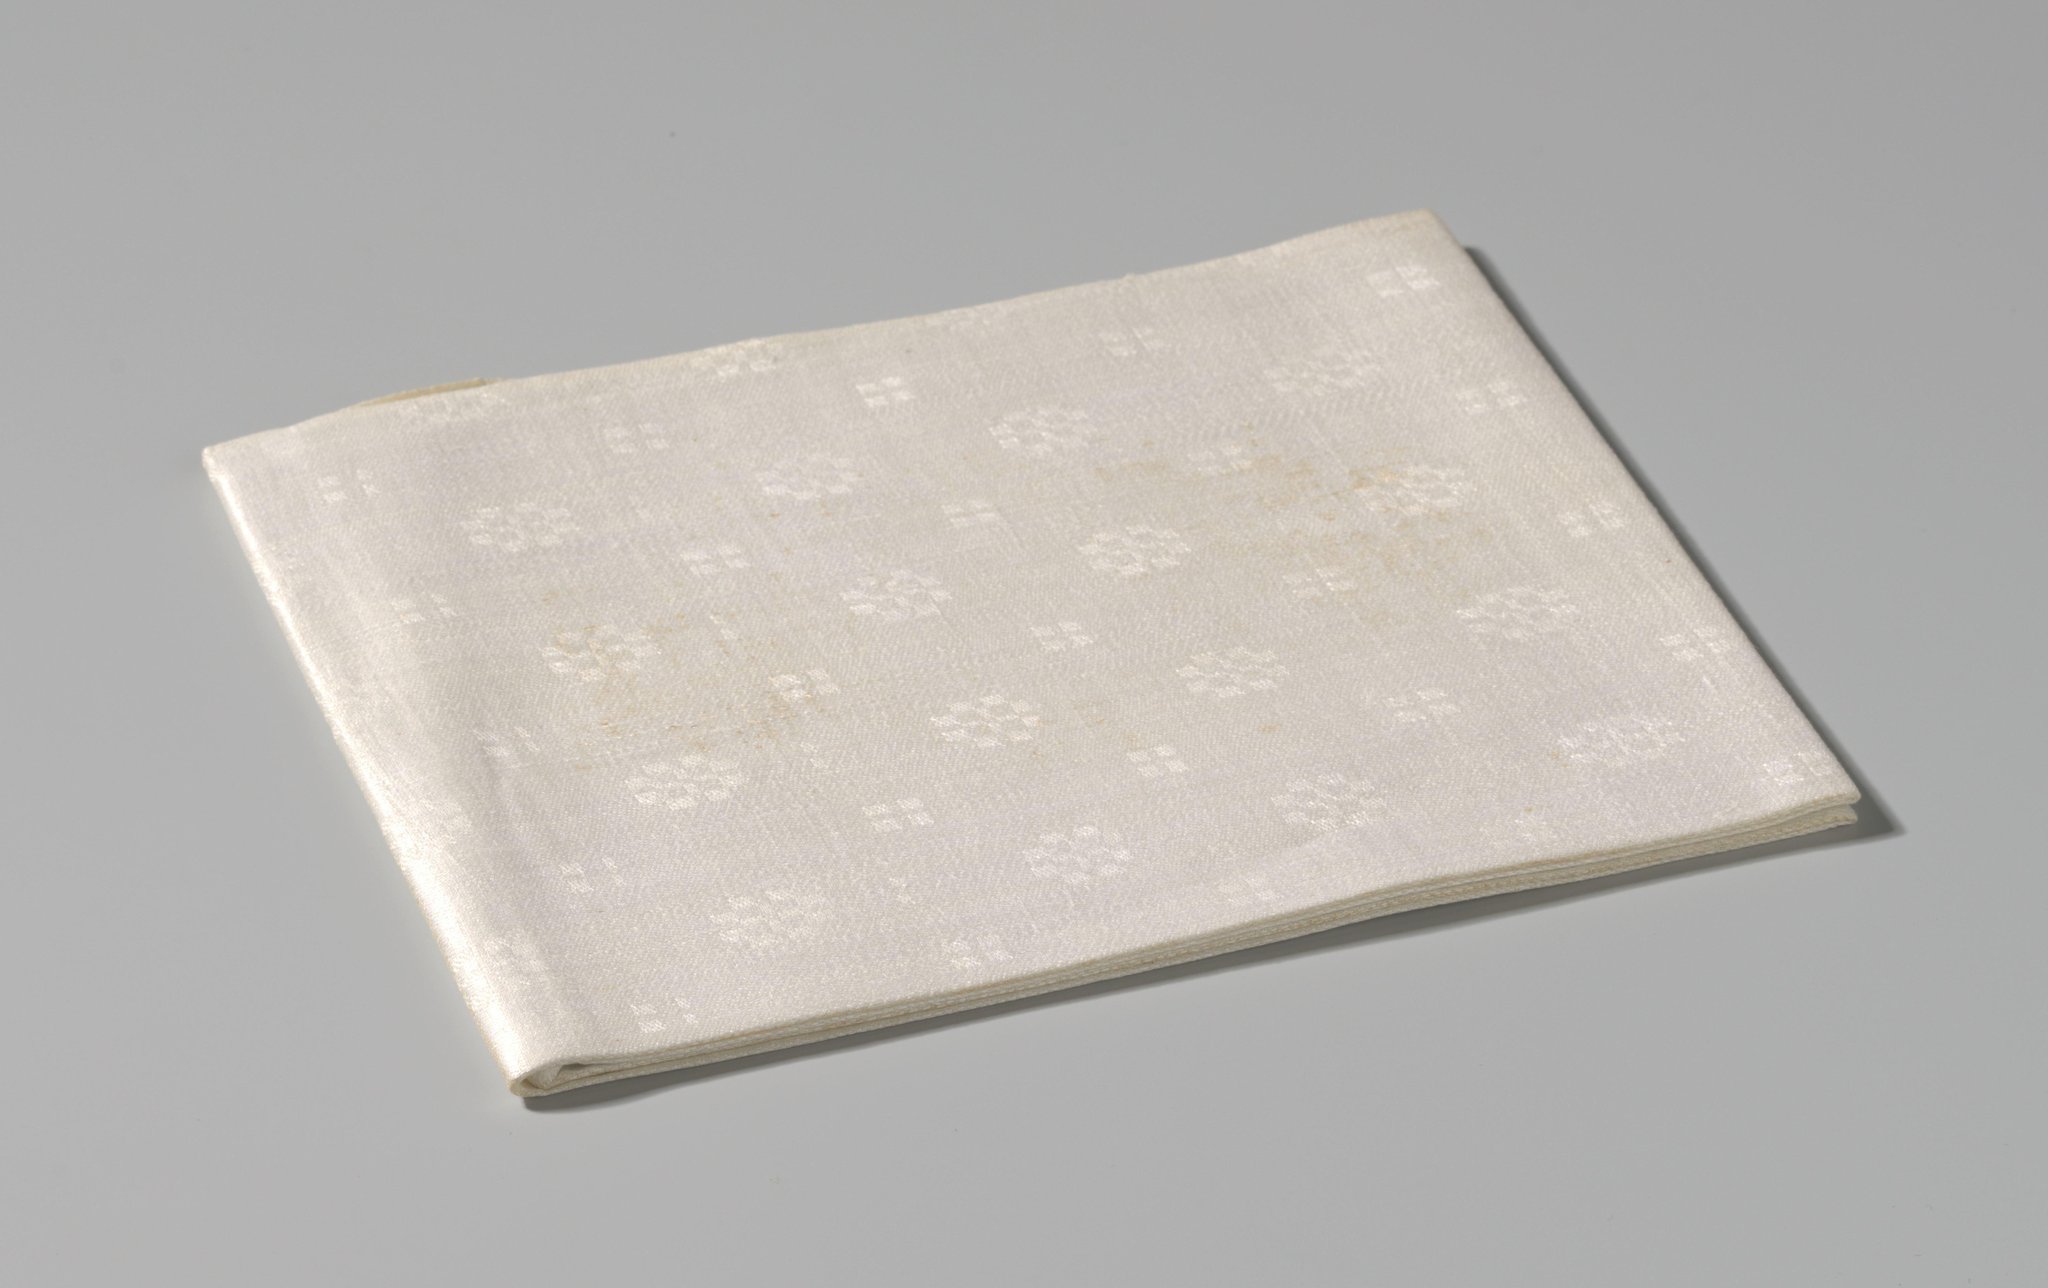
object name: napkin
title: Servet van linnen met pellenpatroon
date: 1850-1875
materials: linen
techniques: peeled fabric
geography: northern netherlands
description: wit linnen servet met een pellen patroon, merk HW 50